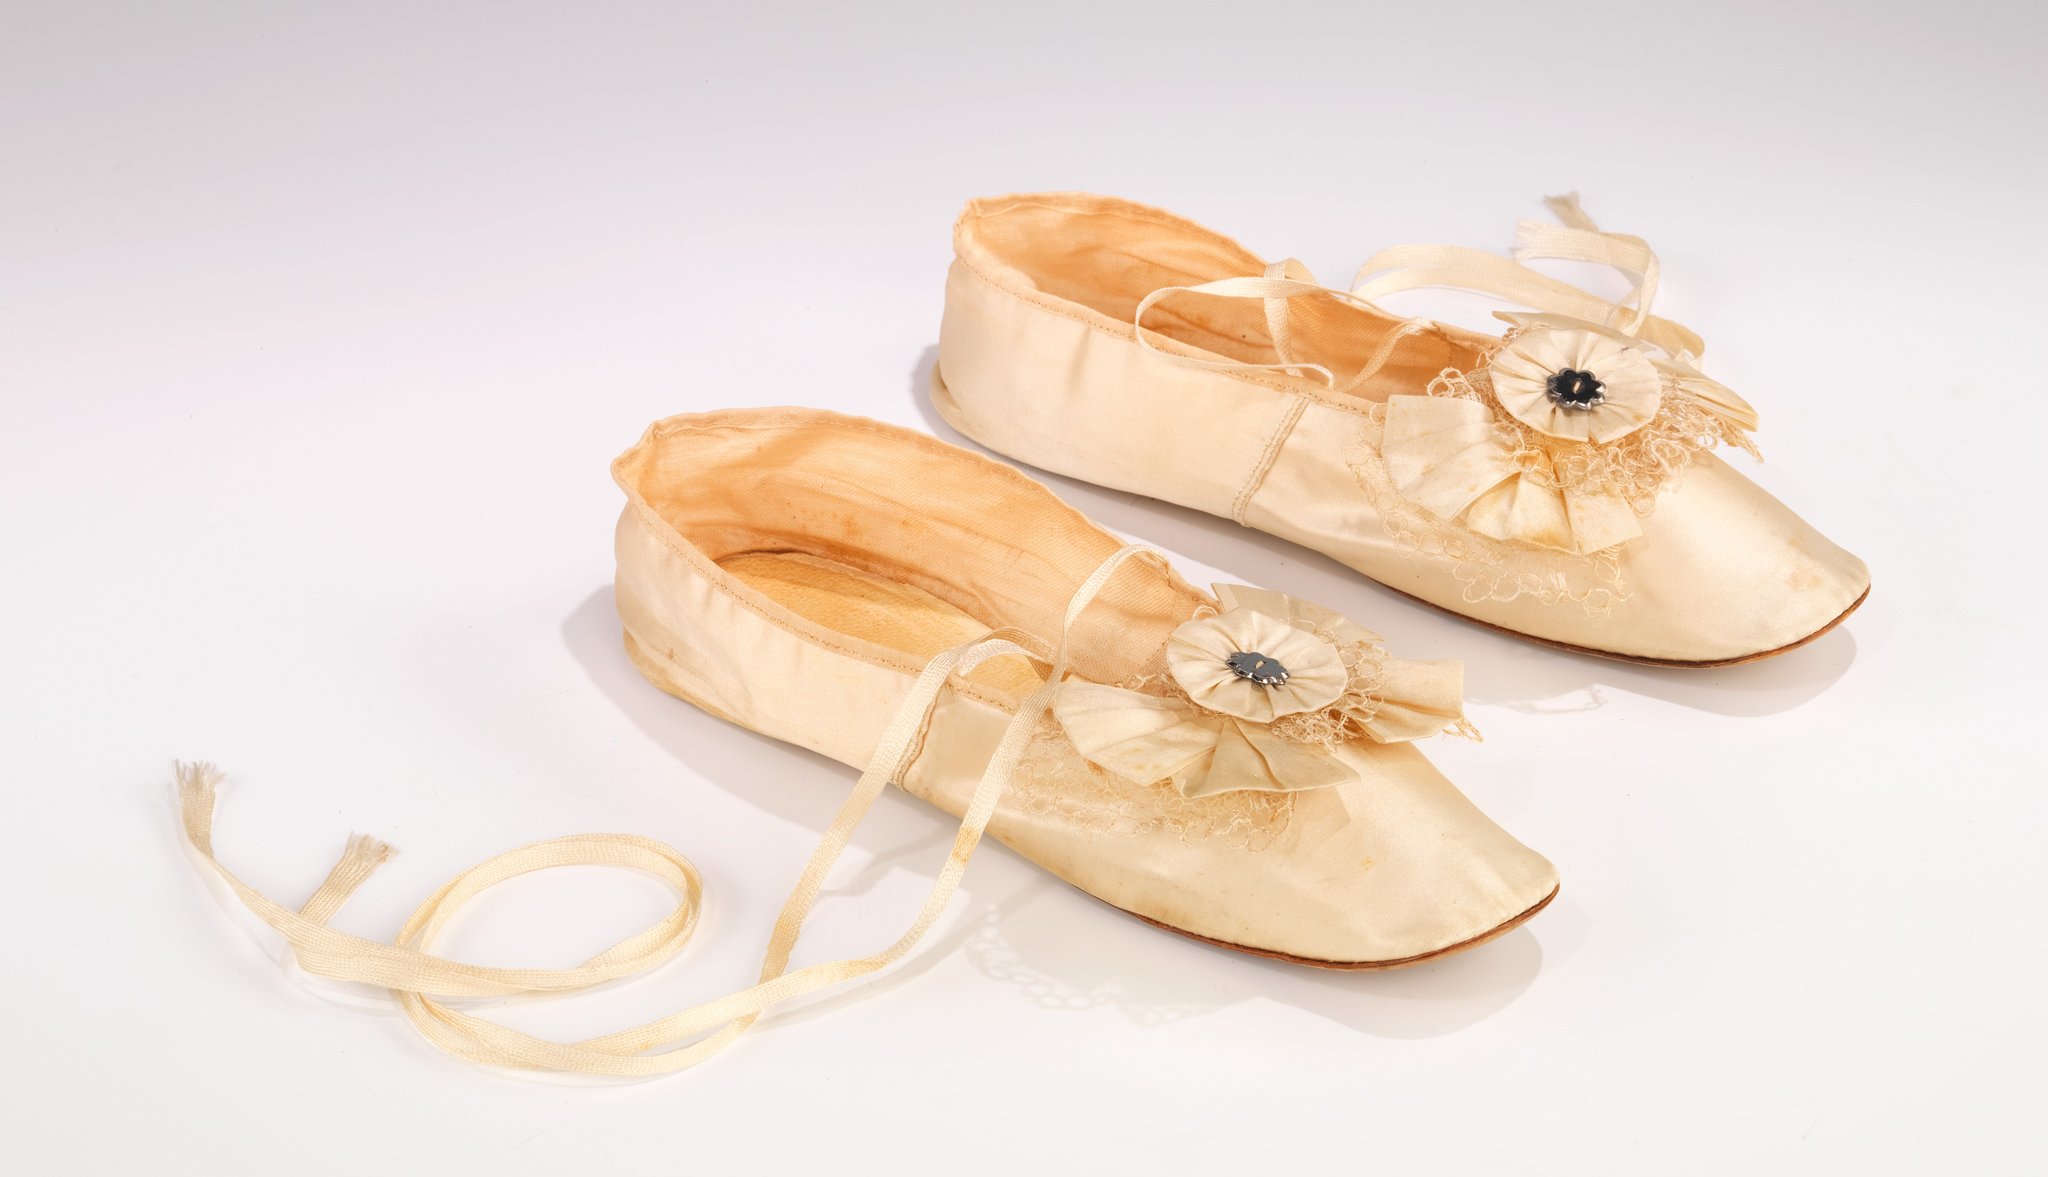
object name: wedding slipper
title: Wedding slippers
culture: french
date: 1857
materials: silk